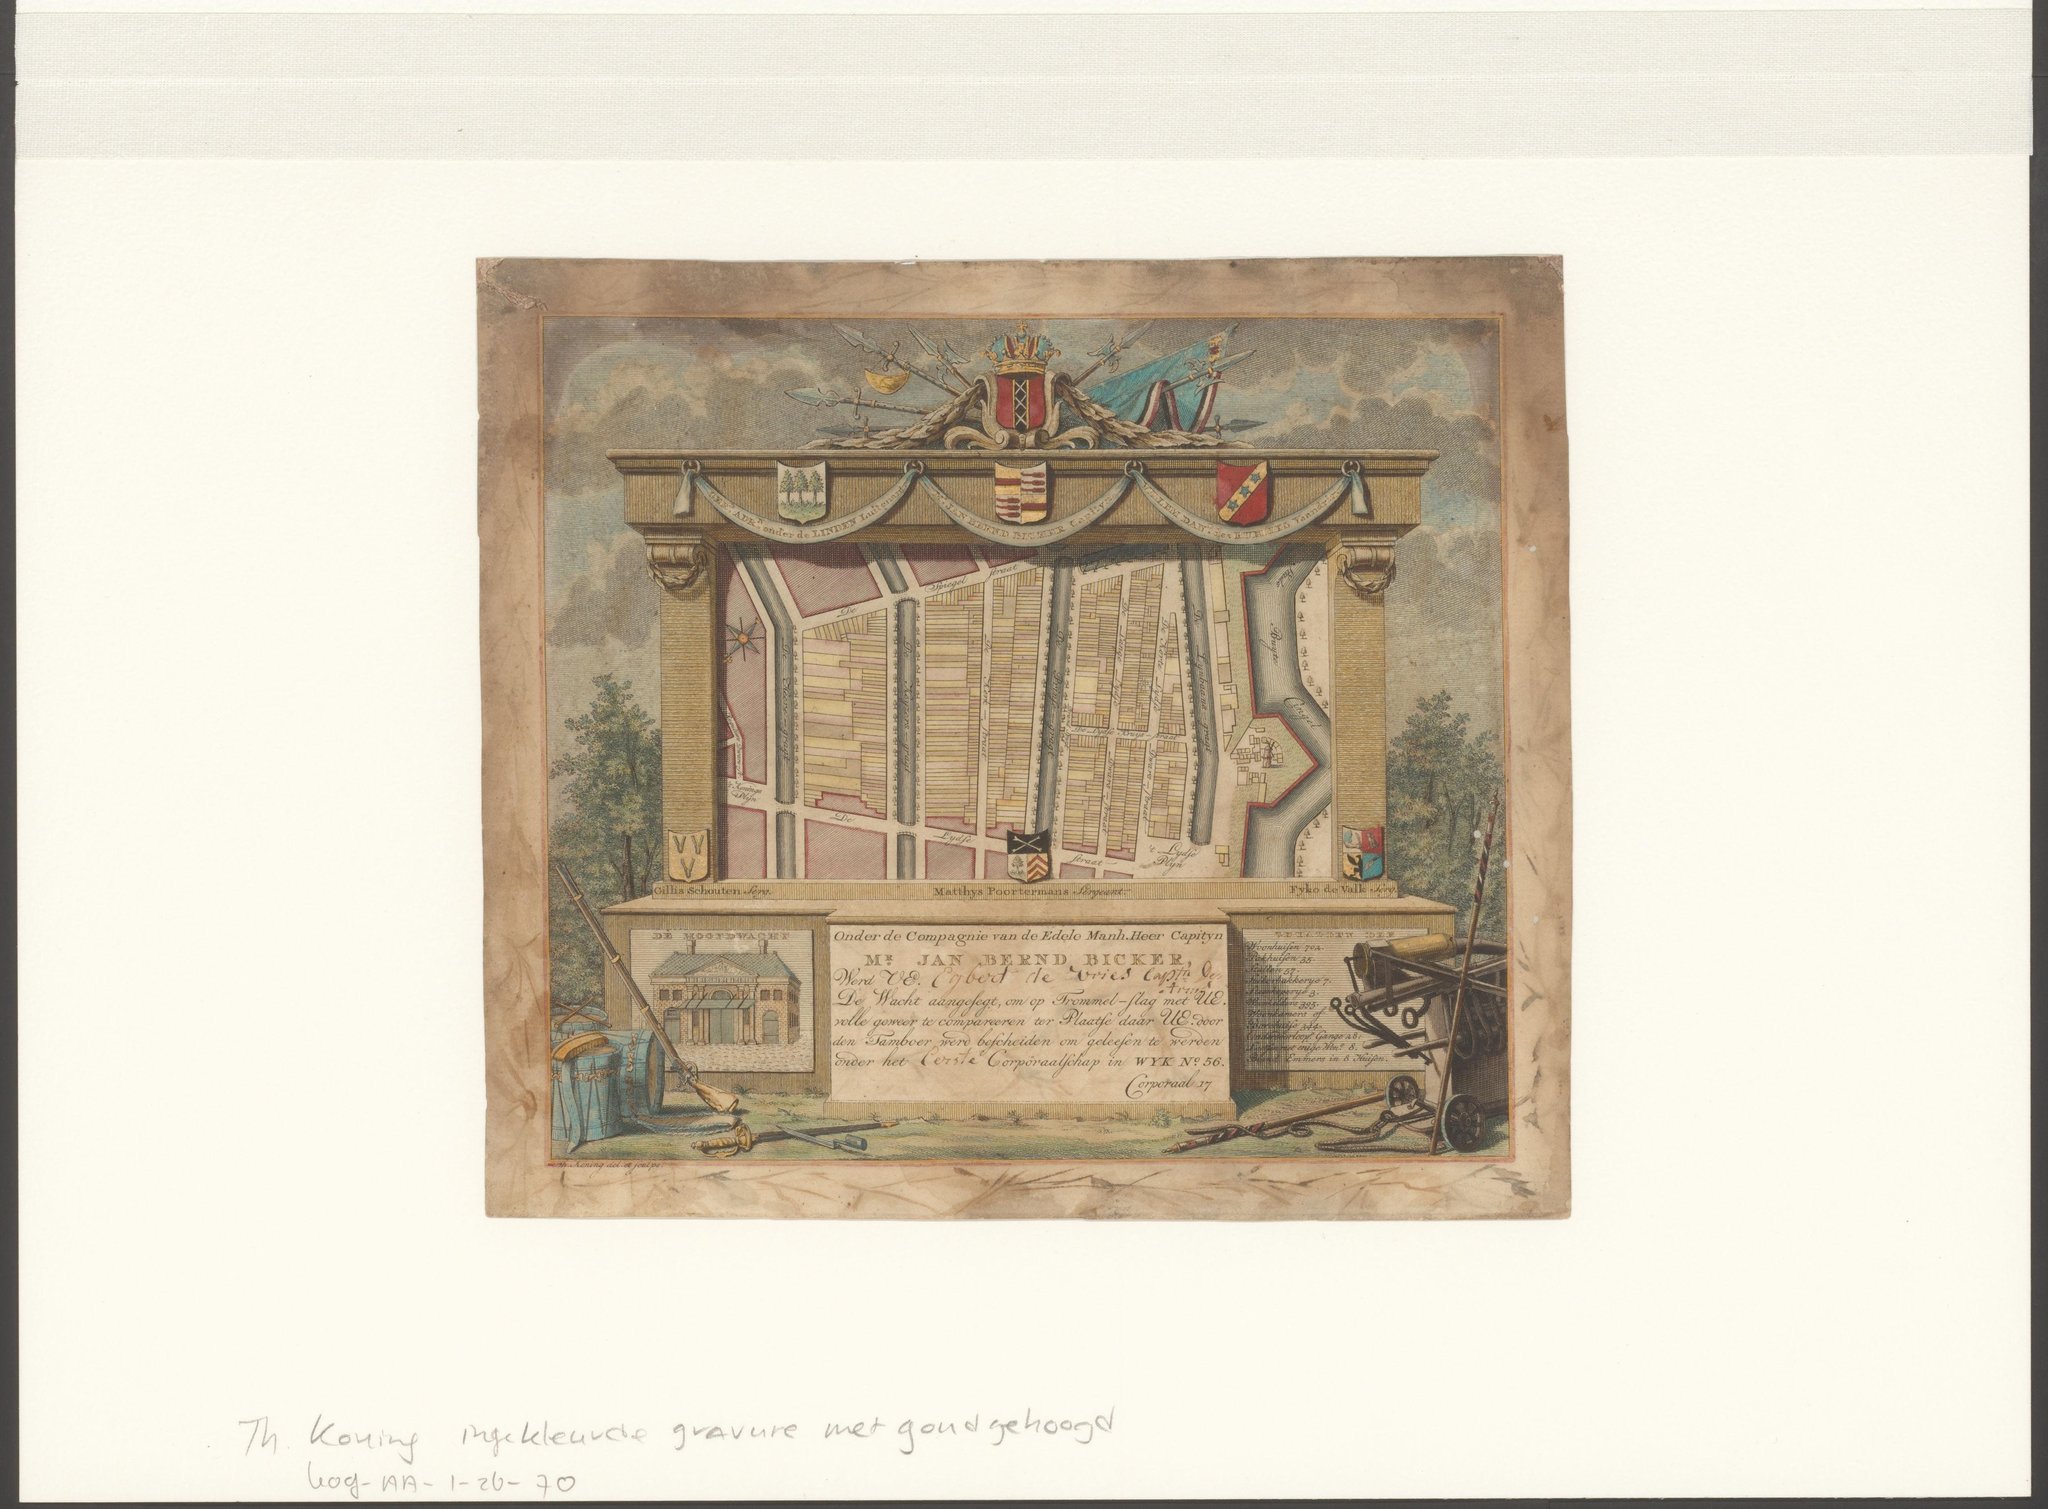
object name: schuttersbiljet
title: Schuttersbrief van kapitein Jan Bernd Bicker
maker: theodoor koning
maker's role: print maker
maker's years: 1748-1829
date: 1779-1787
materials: ink, paper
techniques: brush, engraving, etching, hand coloring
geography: amsterdam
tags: coat of arms (as symbol of the state, etc.) (+ city; municipal), firearms, armorial bearing, heraldry, amsterdam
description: Schuttersbrief met oproep van kapitein Jan Bern Bicker, gericht aan Egbert de Vries, om zich bij het eerste korporaalschap van burgerwijk LVI te Amsterdam te melden. Voorgedrukte brief met open delen die met pen zijn ingevuld. Onderwerpsrubriek binnen de Atlas Amsterdam: Schutters-oproepingsbriefjes.